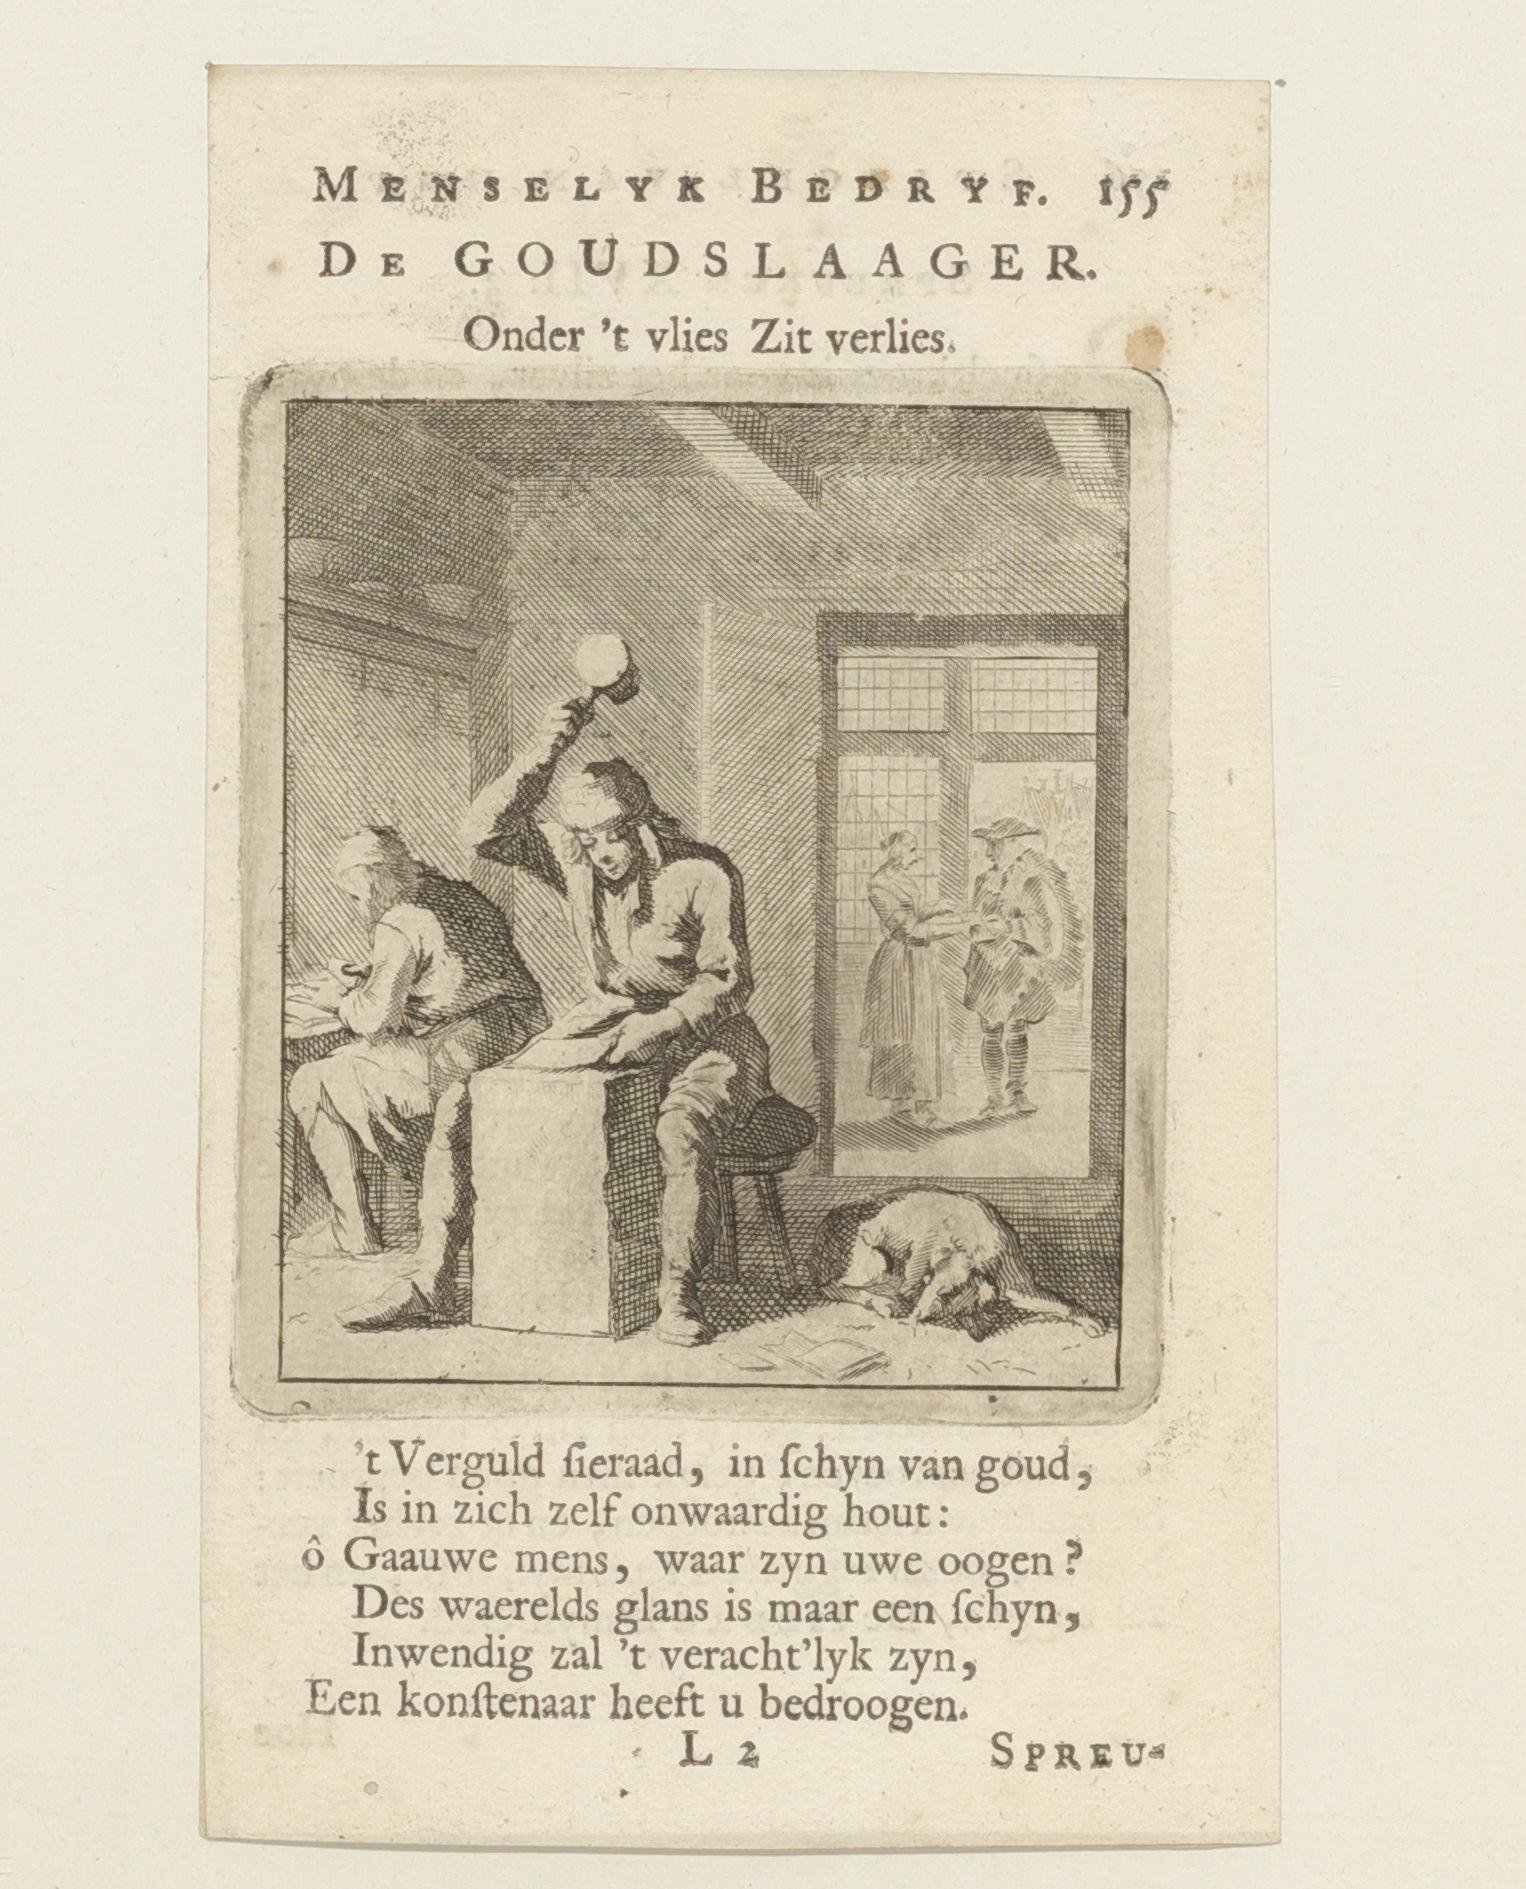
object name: book illustration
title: Goudslager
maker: cornelis van der sys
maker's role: publisher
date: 1718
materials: paper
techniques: etching, letterpress printing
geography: amsterdam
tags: handicrafts, craftsman at work, jeweller, goldsmith, silversmith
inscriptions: collector's mark: Lugt 1641, stamp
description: Prent oorspronkelijk verschenen in de 100-delige serie beroepsprenten van Jan en Caspar Luyken, getiteld: Het menselyk bedryf. S.l.s.n., 1694 (eerste druk). Daarna is de titel en het vers afgesneden. De prenten in diverse publicaties verschenen en gekopieerd. Huidige staat uit: Luyken, Jan en Caspar. Spiegel van het menselyk bedryf (...). Amsterdam: Cornelis van der Sys, 1718, p. 155. Prent waarschijnlijk ook gebruikt in eerdere (1704) en latere (1730, 1749, 1767) publicaties.